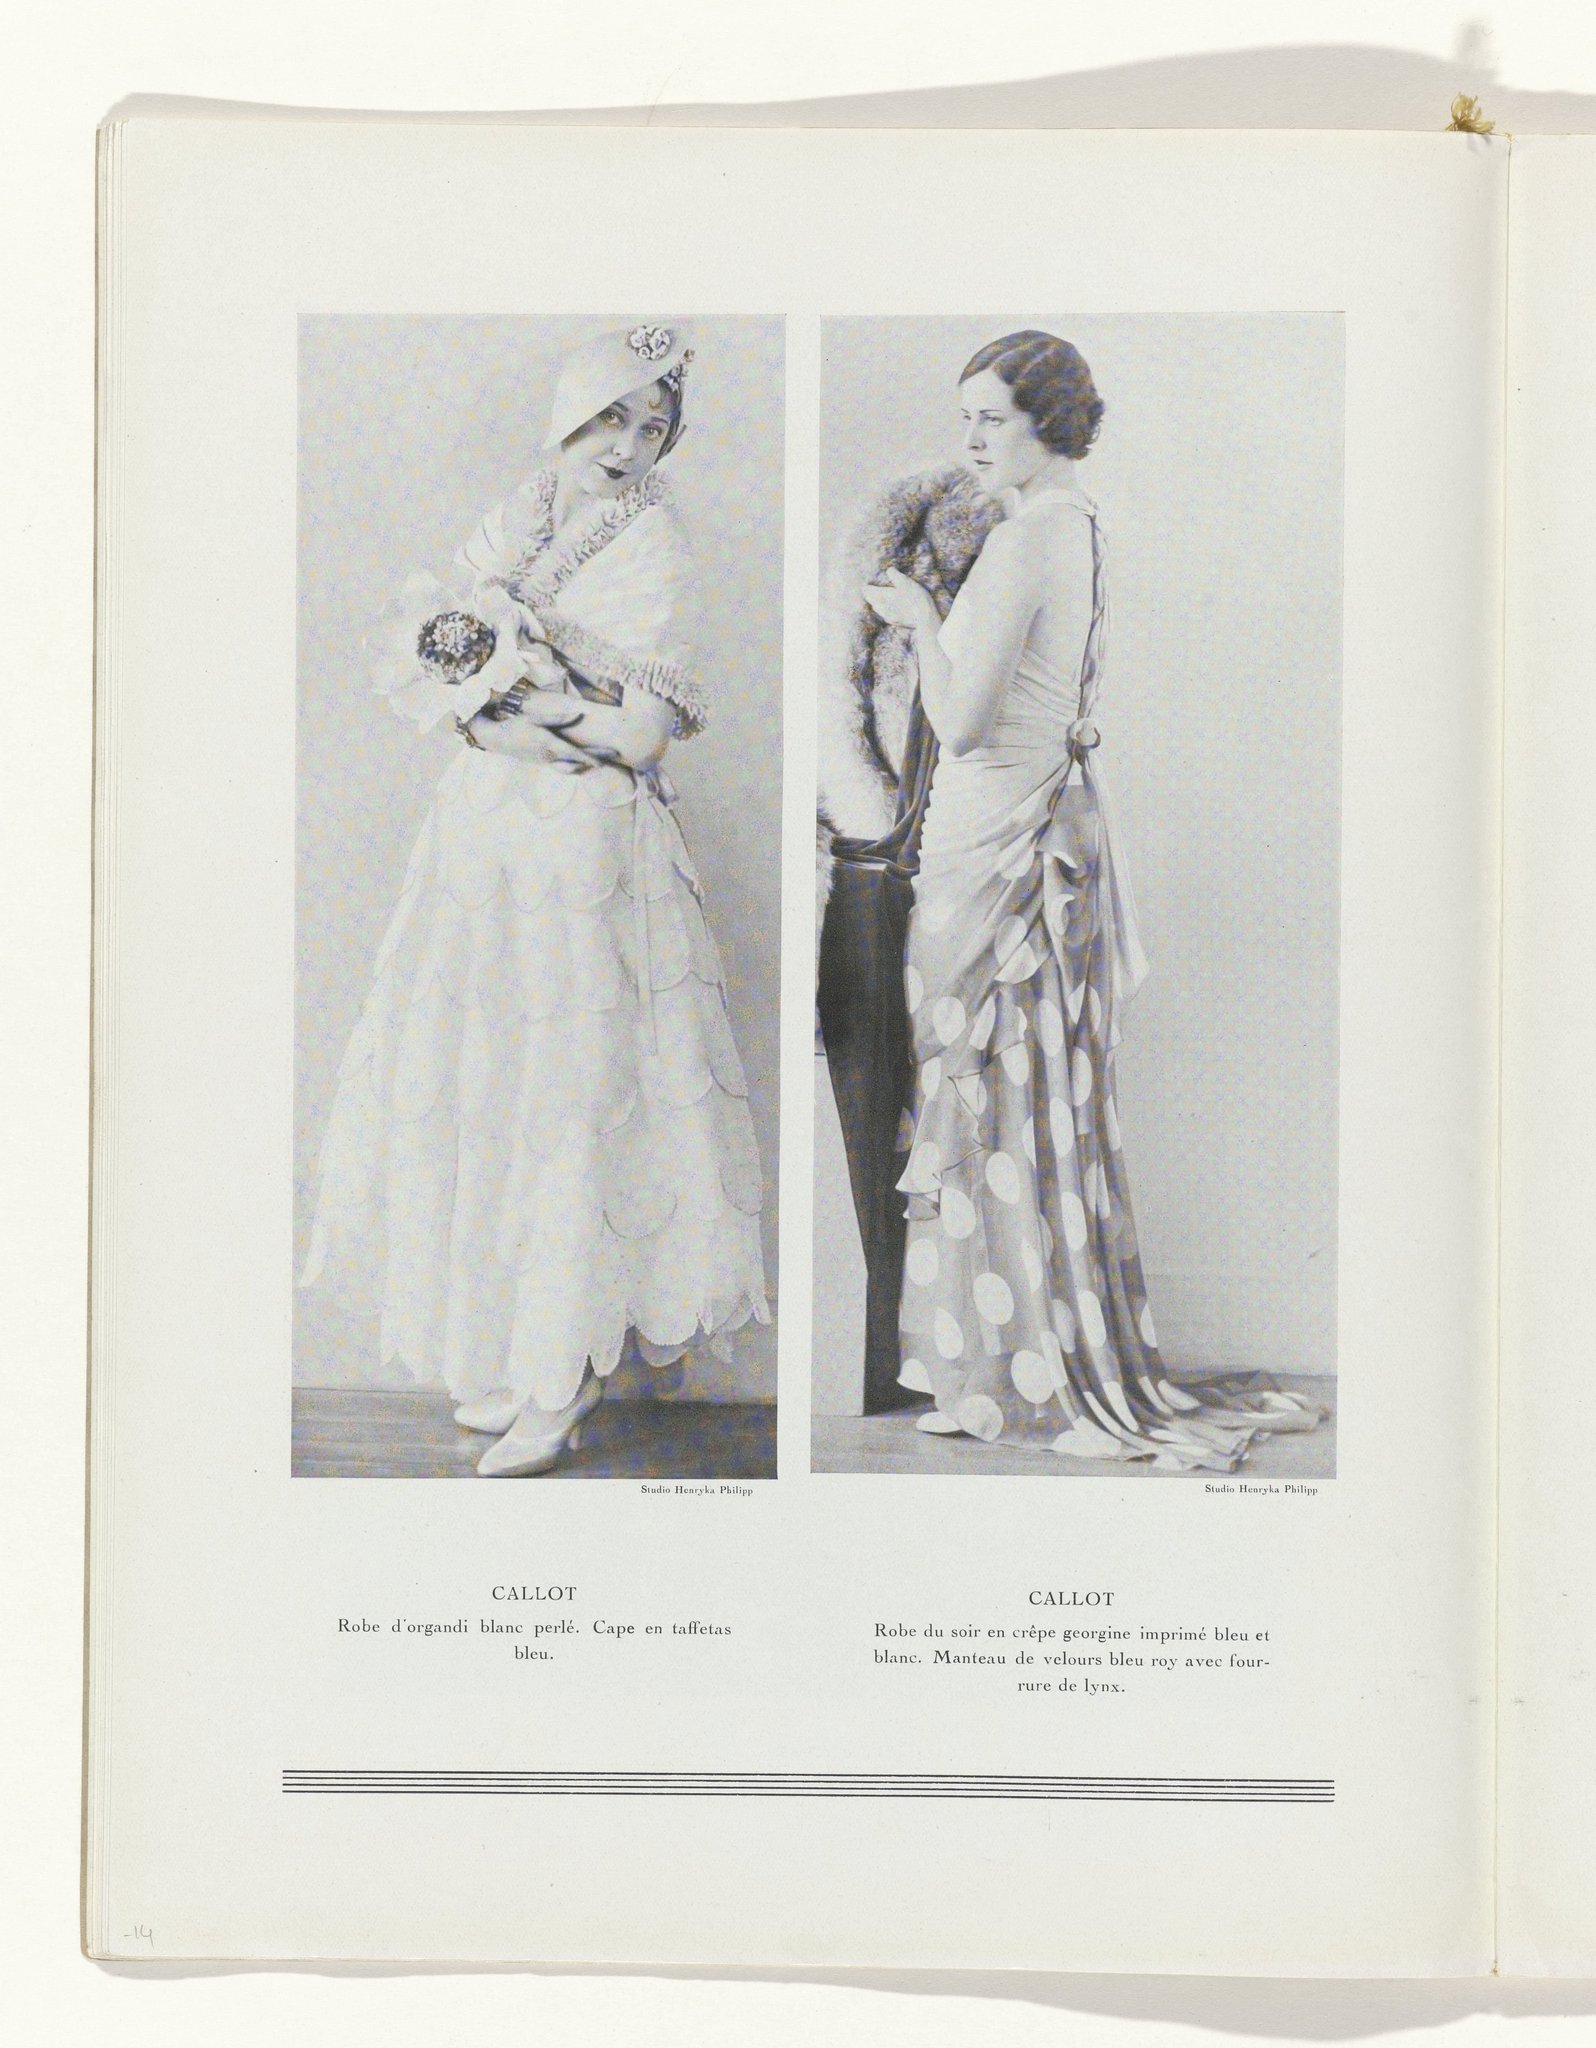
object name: magazine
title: Art - Goût - Beauté, Feuillets de l' élégance féminine, Juin 1932, No. 142, 12e Année, p. 14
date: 1932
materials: paper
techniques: photography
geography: paris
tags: dress, gown: evening dress (+ women's clothes), coat (+ women's clothes), cape (+ women's clothes), fashion plates, head-gear: hat (+ women's clothes)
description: Twee japonnen van Callot. Links: jurk van witte organdi en cape van blauwe tafzijde. Rechts: avondjurk van bedrukte crêpe georgine in wit en blauw. mantel van koningsblauw fluweel met lynx bont. Pagina uit het modetijdschrift Art-Goût-Beauté (1920-1933).